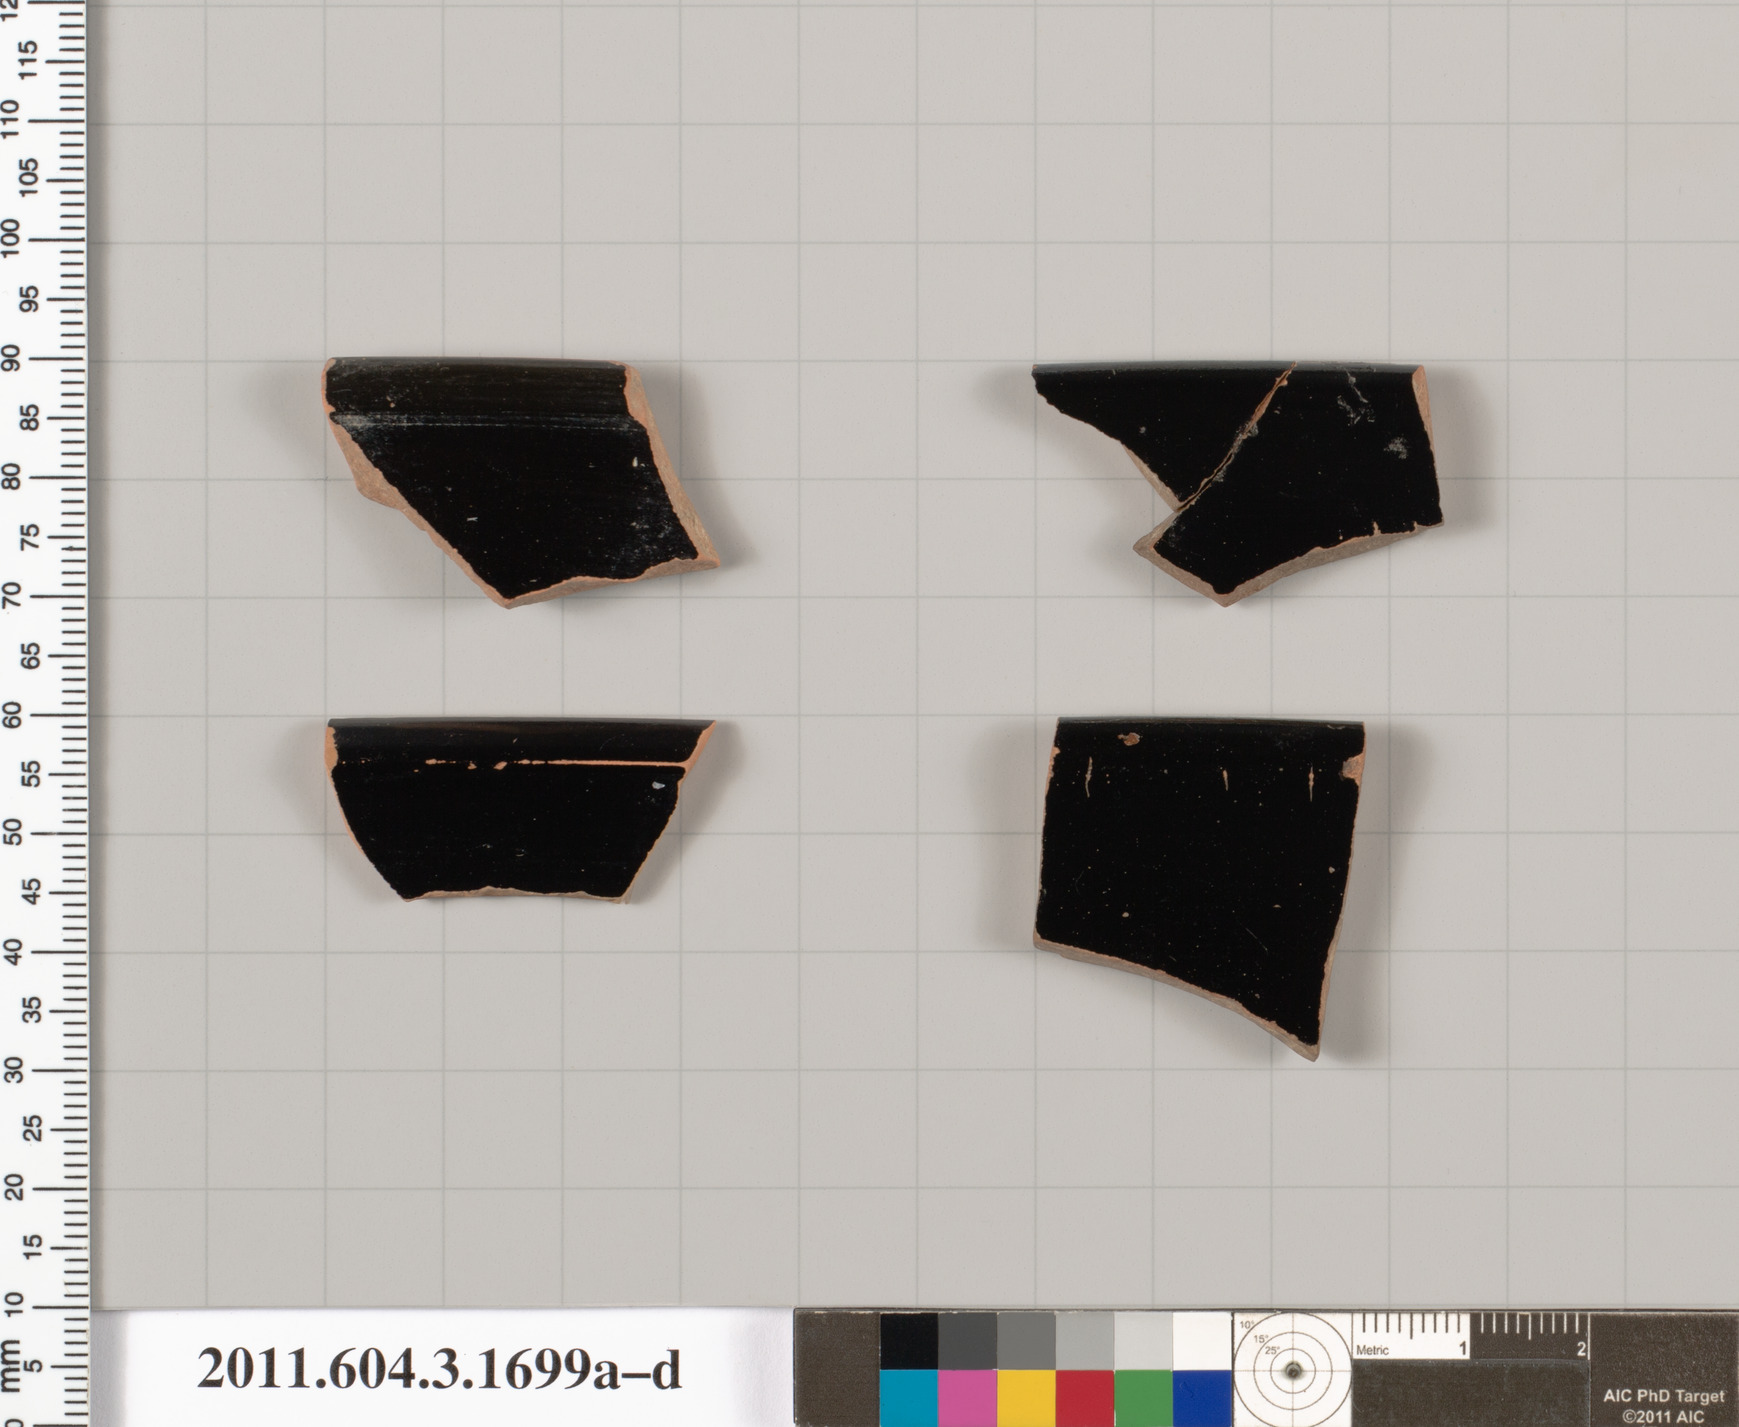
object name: kylix fragment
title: Terracotta rim fragments of kylikes: Band cups (drinking cups)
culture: greek, attic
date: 550-526 BCE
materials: terracotta